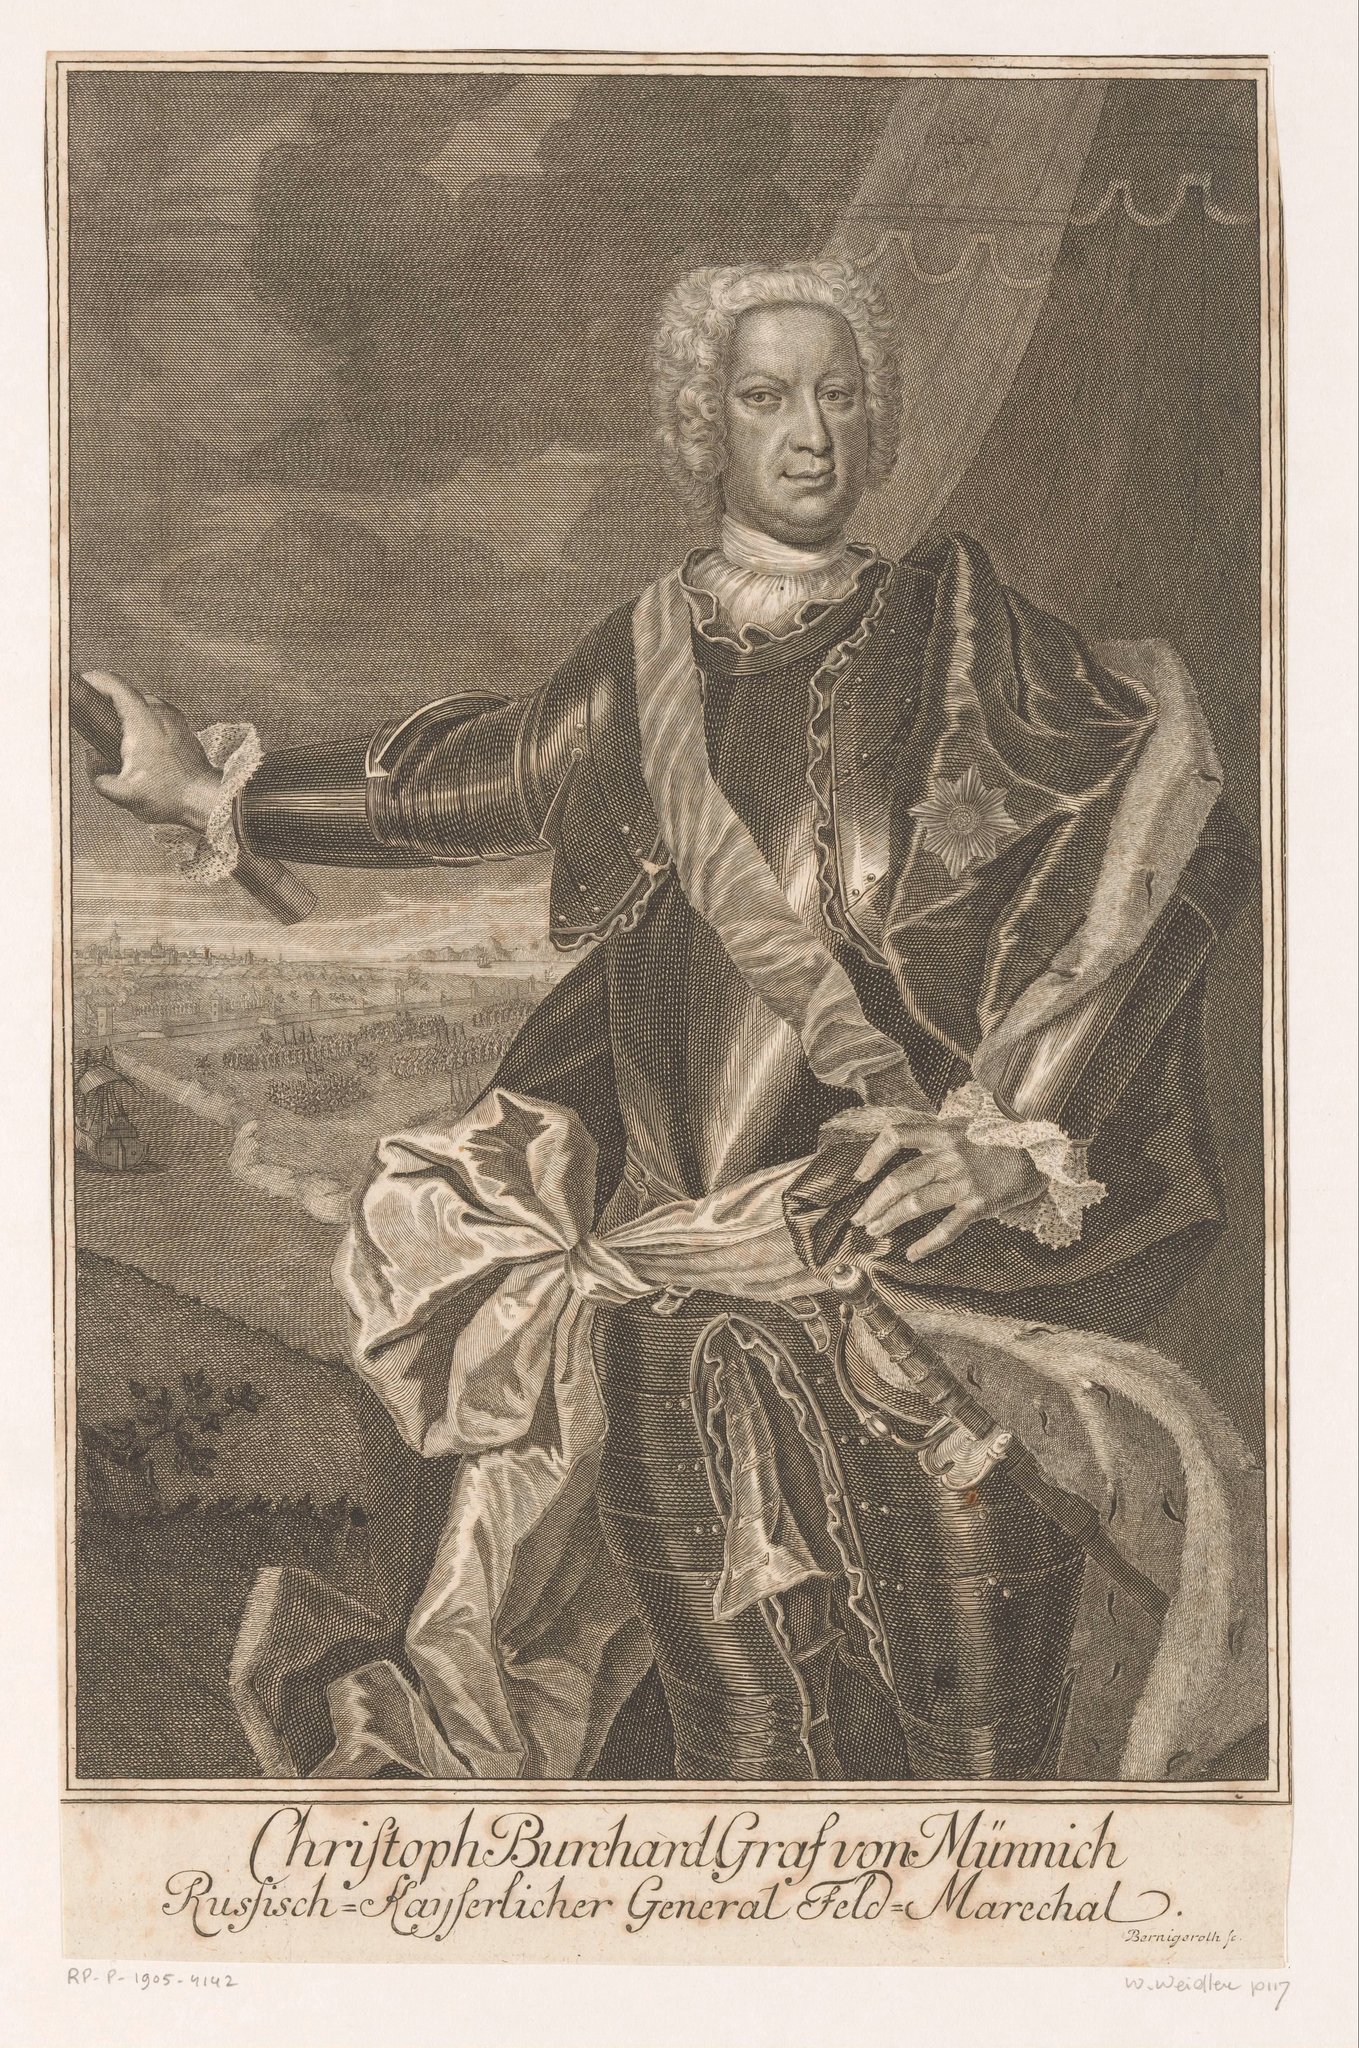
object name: print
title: Portret van Burchard Christoph Graf von Münnich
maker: johann martin bernigeroth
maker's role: print maker, publisher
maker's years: 1713-1767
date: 1730-1767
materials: paper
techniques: engraving, etching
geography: leipzig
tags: knighthood order, armour, historical persons, defence ~ siege, baton of general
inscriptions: collector's mark: Lugt 2228